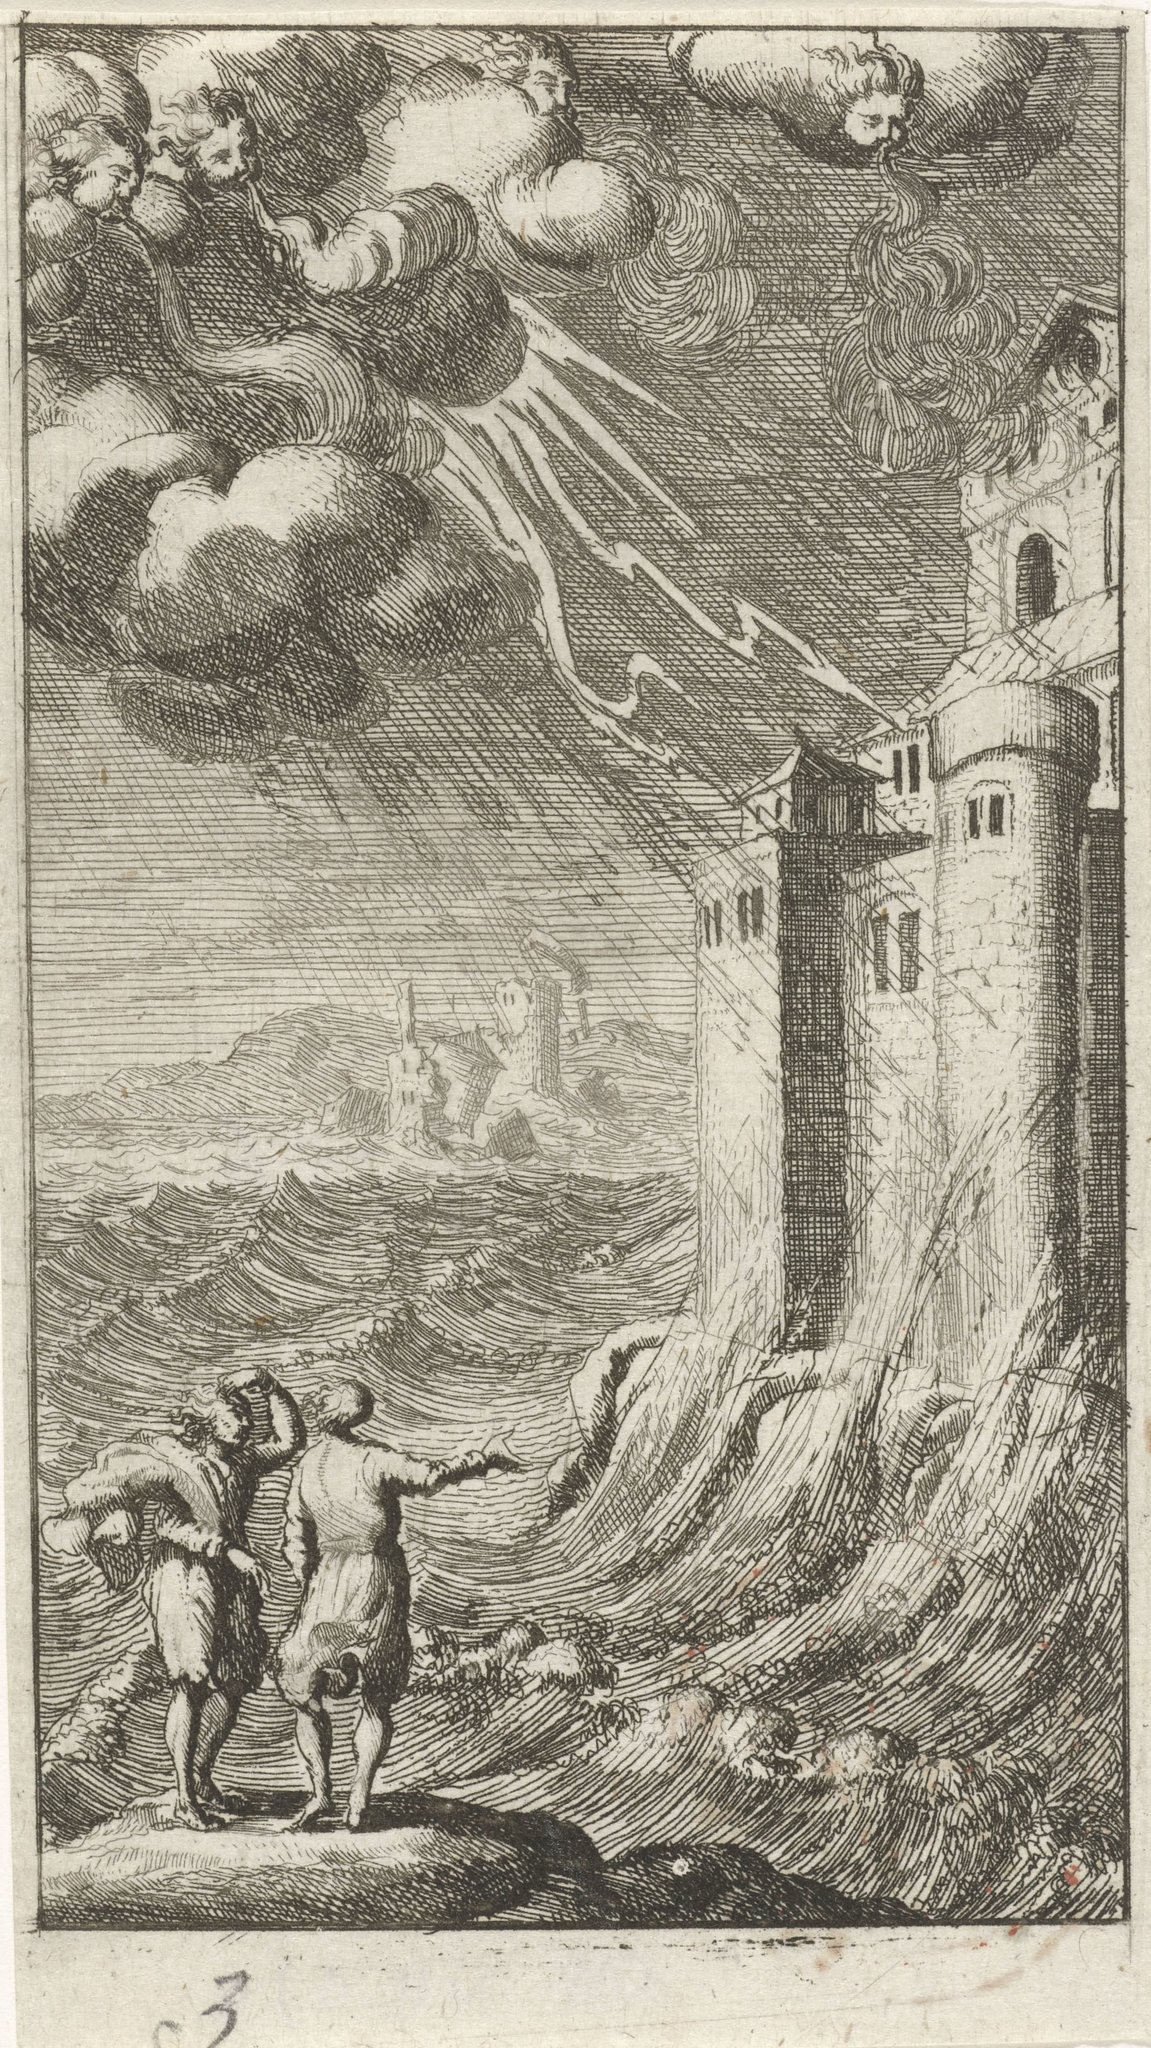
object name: print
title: Het huis op de rots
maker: Anonymous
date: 1681-1762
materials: paper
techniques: etching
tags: house built upon a rock; house built upon sand ~ doctrine of christ on love, etc. (matthew 7:24-27; luke 6:47-49)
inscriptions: collector's mark: Lugt 240, number: ‘3’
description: Kopie naar prent van J. Luyken, mogelijk voor het eerst verschenen in: Het Nieuwe Testament ofte alle Boecken des Nieuwen Verbondts onses Heeren Iesu Christi. Amsterdam: Hieronymus Sweerts, Jan ten Hoorn, Jan Bouman en Daniel van den Dalen, 1681.